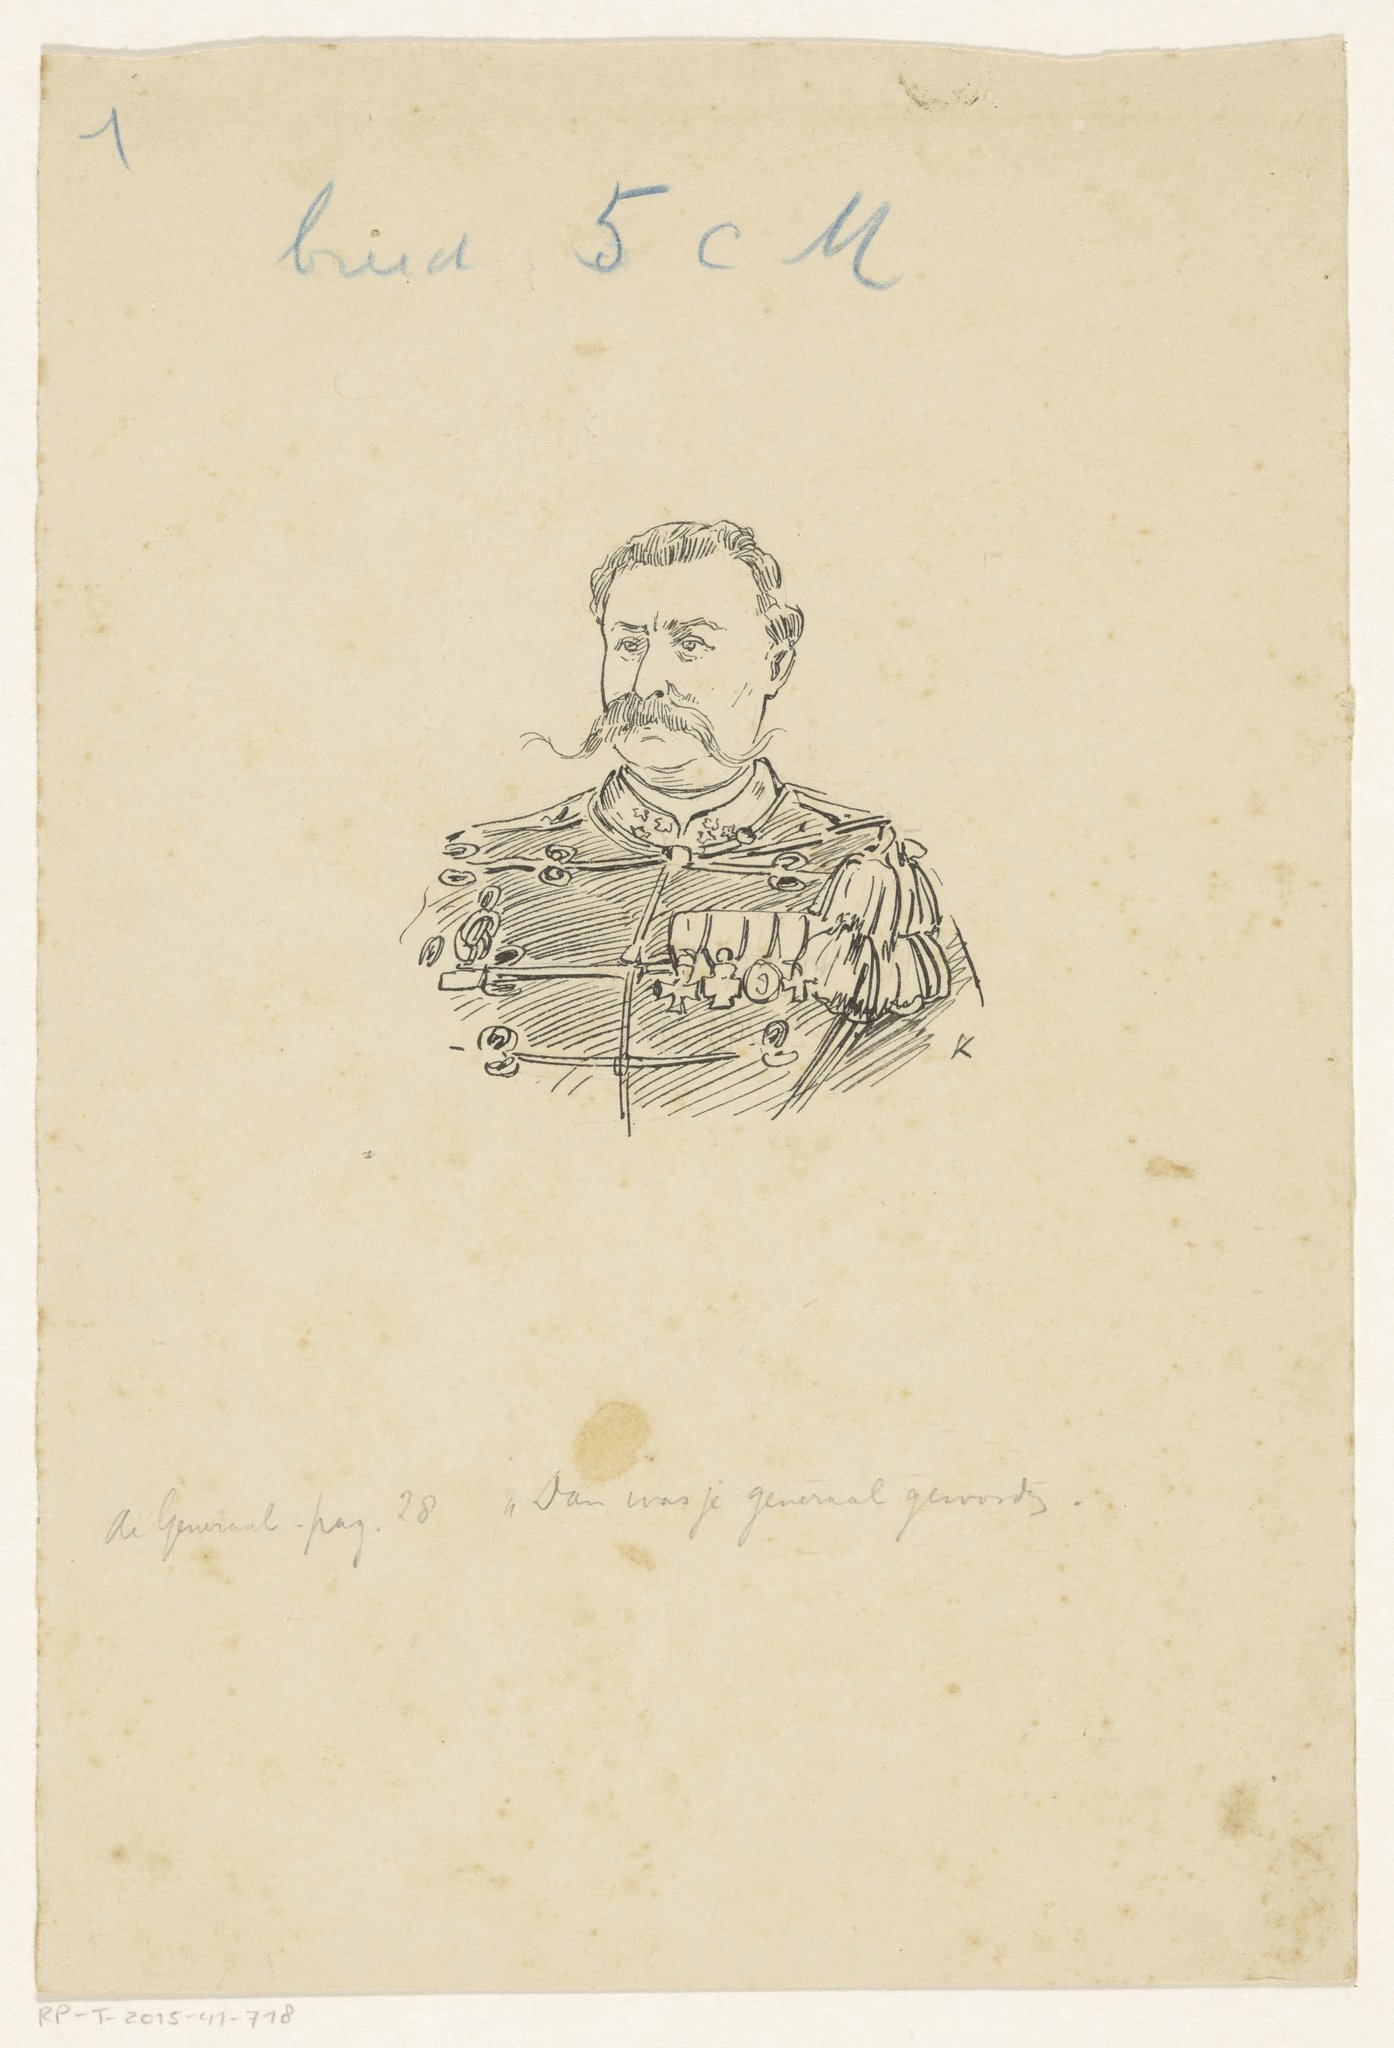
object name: boekillustratie ontwerp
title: Man met snor in militair uniform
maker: heinrich m. krabbé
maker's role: draughtsman, print maker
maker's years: 1868-1931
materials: ink, paper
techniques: pen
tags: knighthood order, (military) uniforms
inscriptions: :, annotation: ‘de Generaal. pag. 28/ "Dan was je generaal geworden.’, collector's mark: Lugt 2228, number: ‘1’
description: Ontwerp voor: Harpen, N. van. Toevalstreffers. Amsterdam: Veen, 1898.